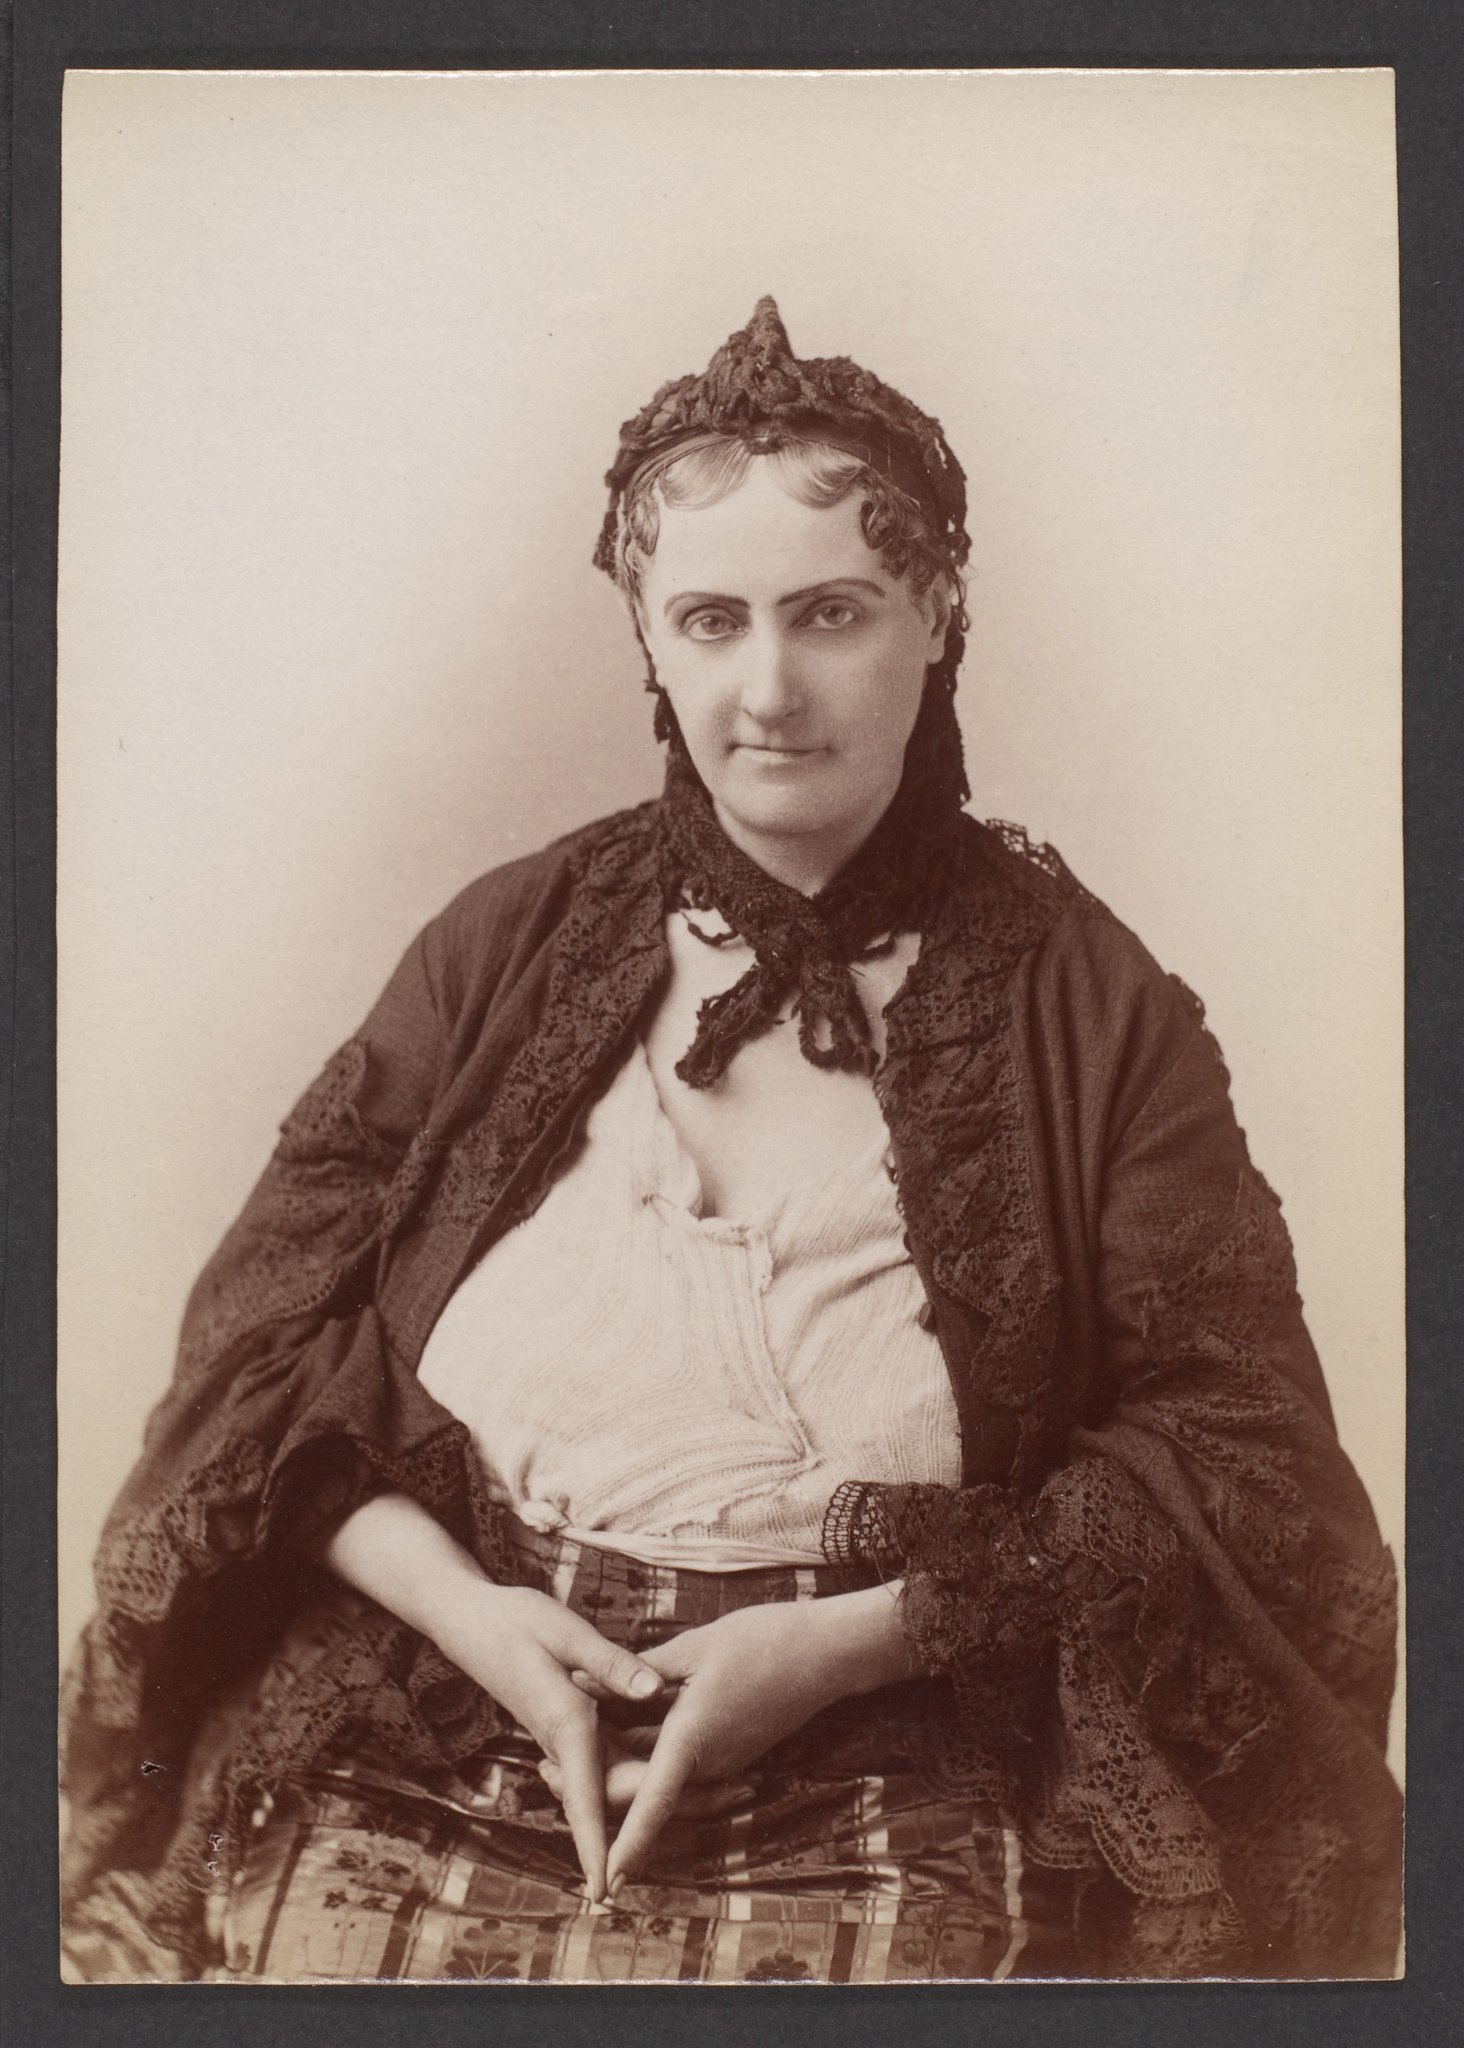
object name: photograph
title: Ti-fille Brune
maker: pierre-louis pierson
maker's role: artist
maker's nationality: french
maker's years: 1822-1913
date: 1895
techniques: albumen silver print, glass negative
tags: portraits,women